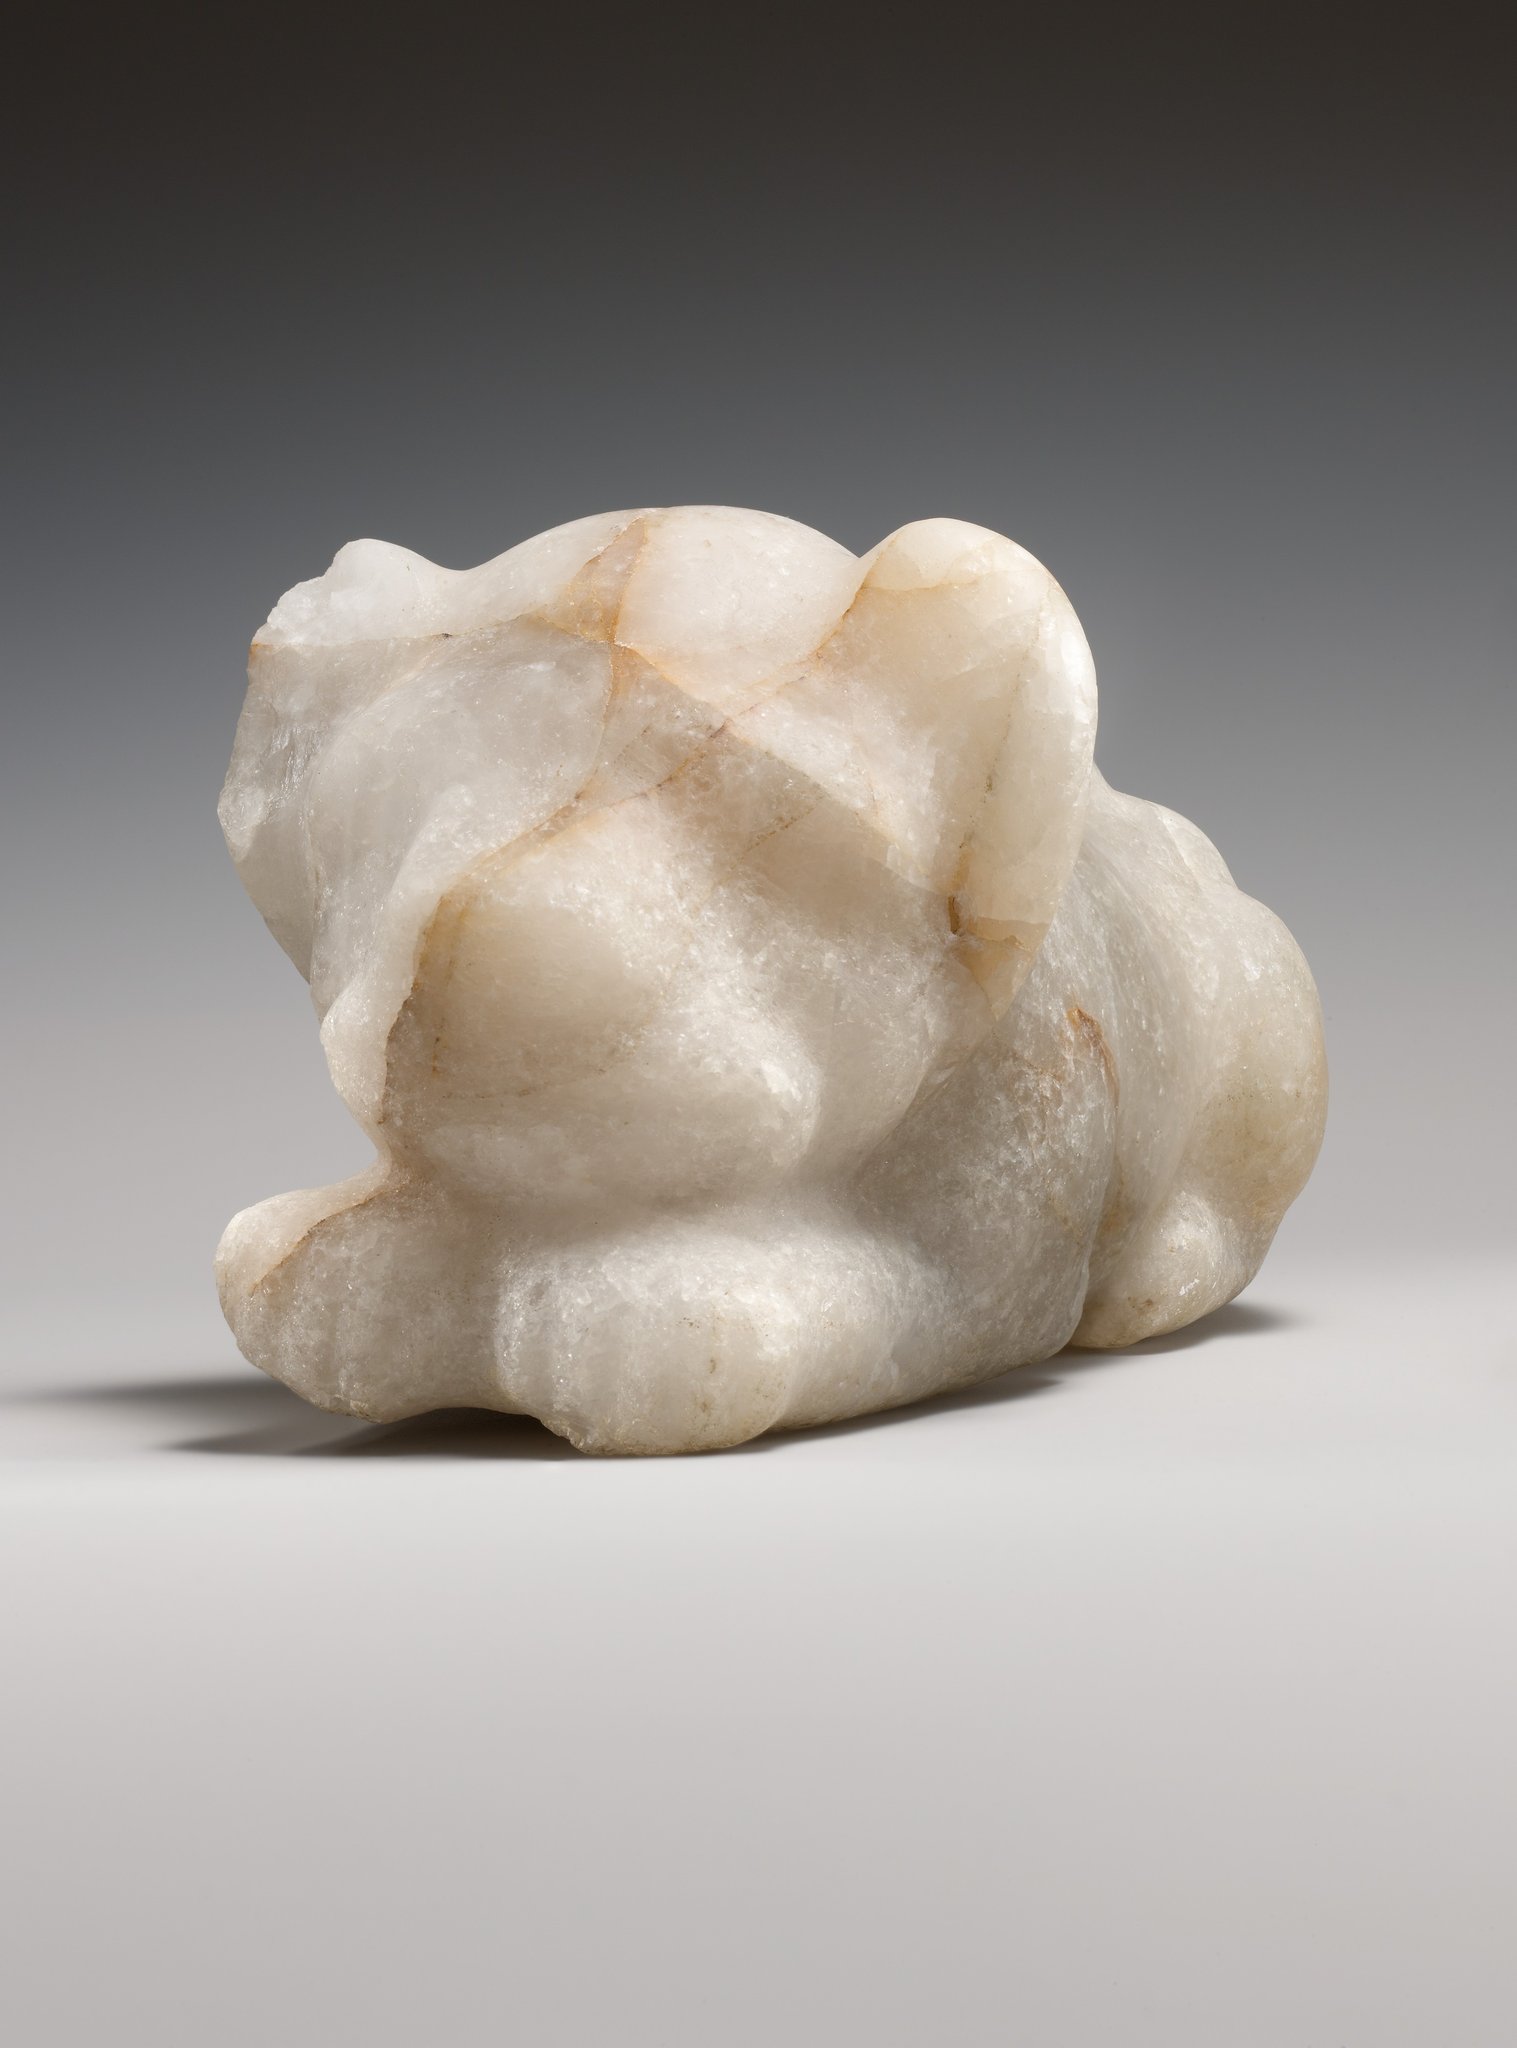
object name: statuette, animal, lion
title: Lion Cub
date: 3100-2900 BCE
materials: quartzite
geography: southern upper egypt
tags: lions